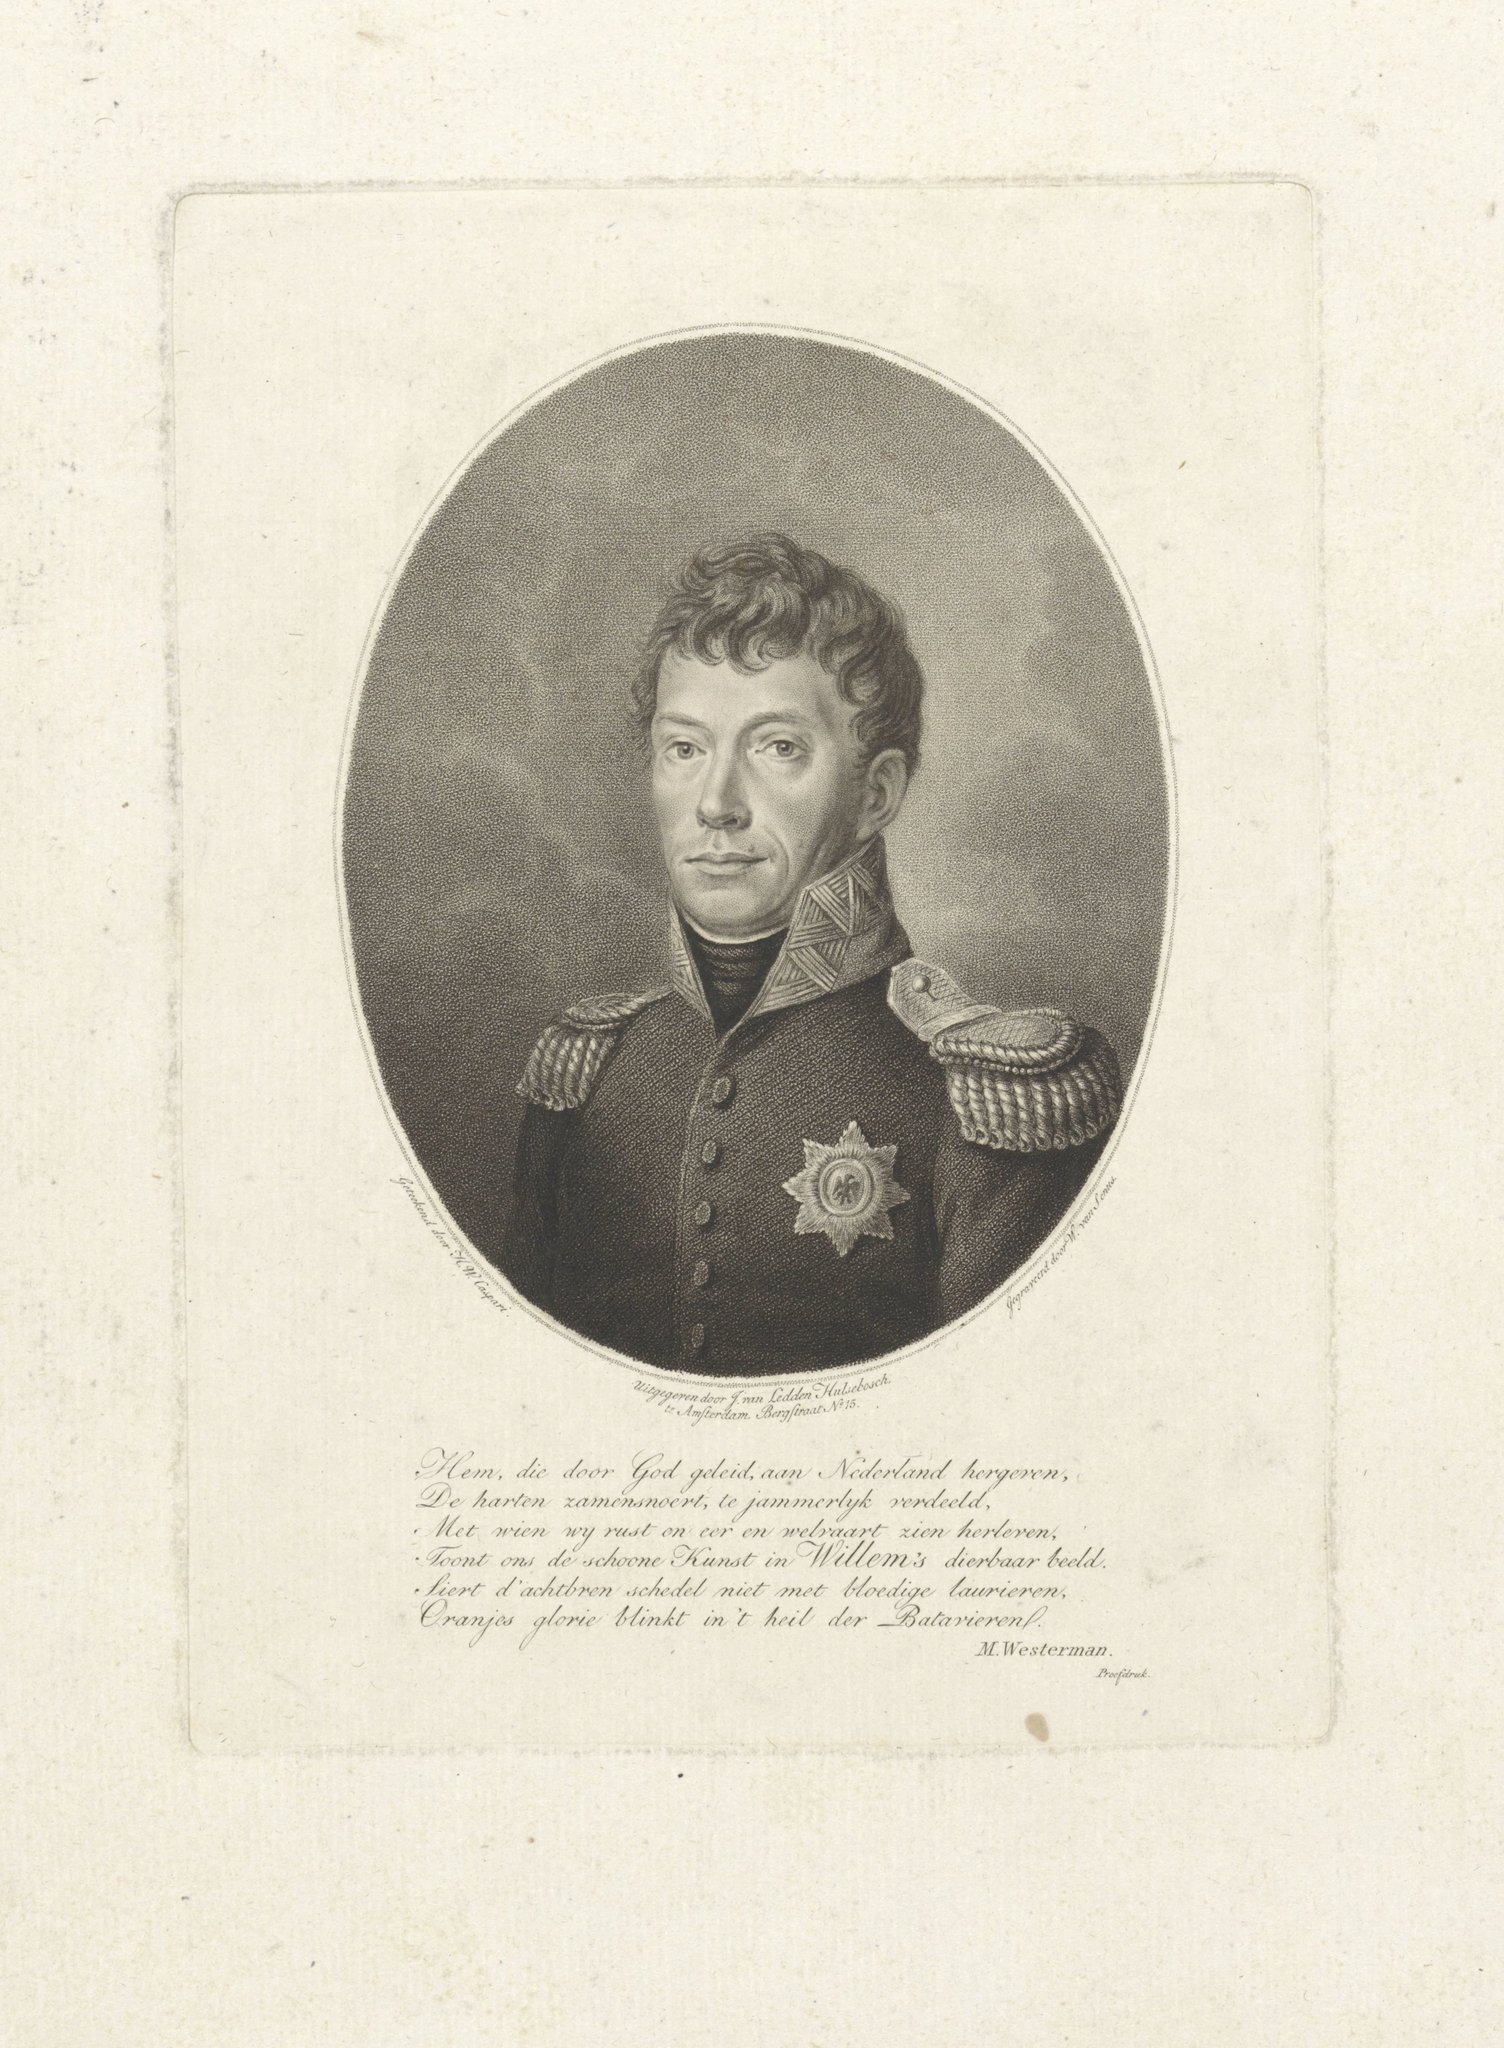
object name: print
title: Portret van Willem I Frederik (koning der Nederlanden)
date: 1814-1843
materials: paper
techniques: engraving, etching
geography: amsterdam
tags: the hague, berlin, william i of the netherlands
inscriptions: collector's mark: Lugt 2228